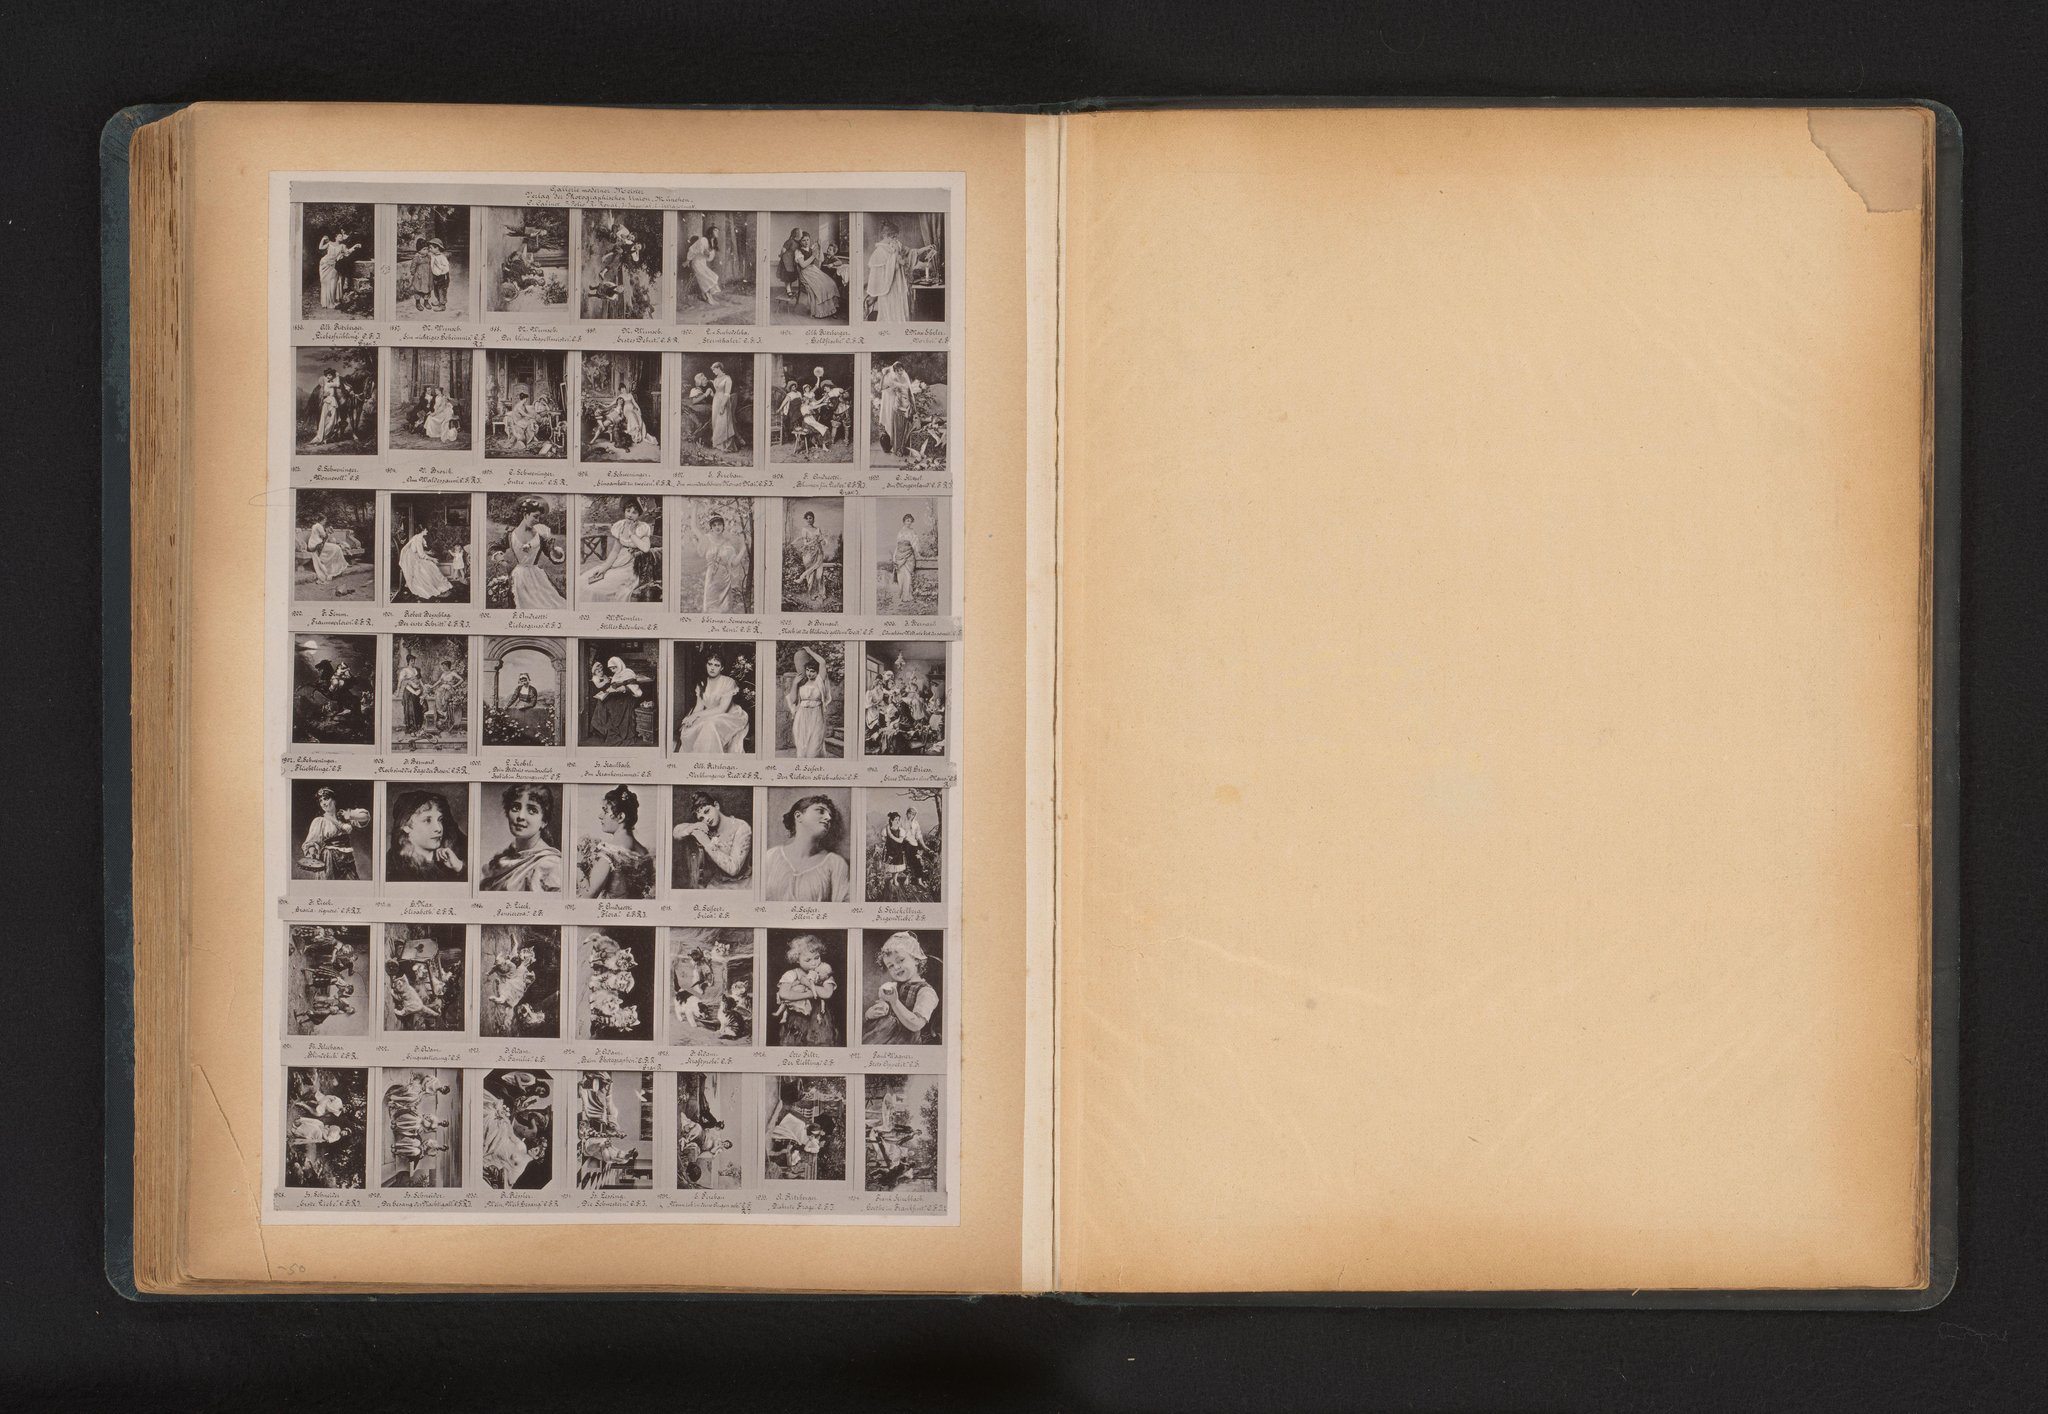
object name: page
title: Gallerie moderner Meister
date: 1880-1885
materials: paper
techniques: photograph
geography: berlin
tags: historical persons not known by name - bb - woman, historical persons not known by name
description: Prent op vijftigste ongenummerde pagina.